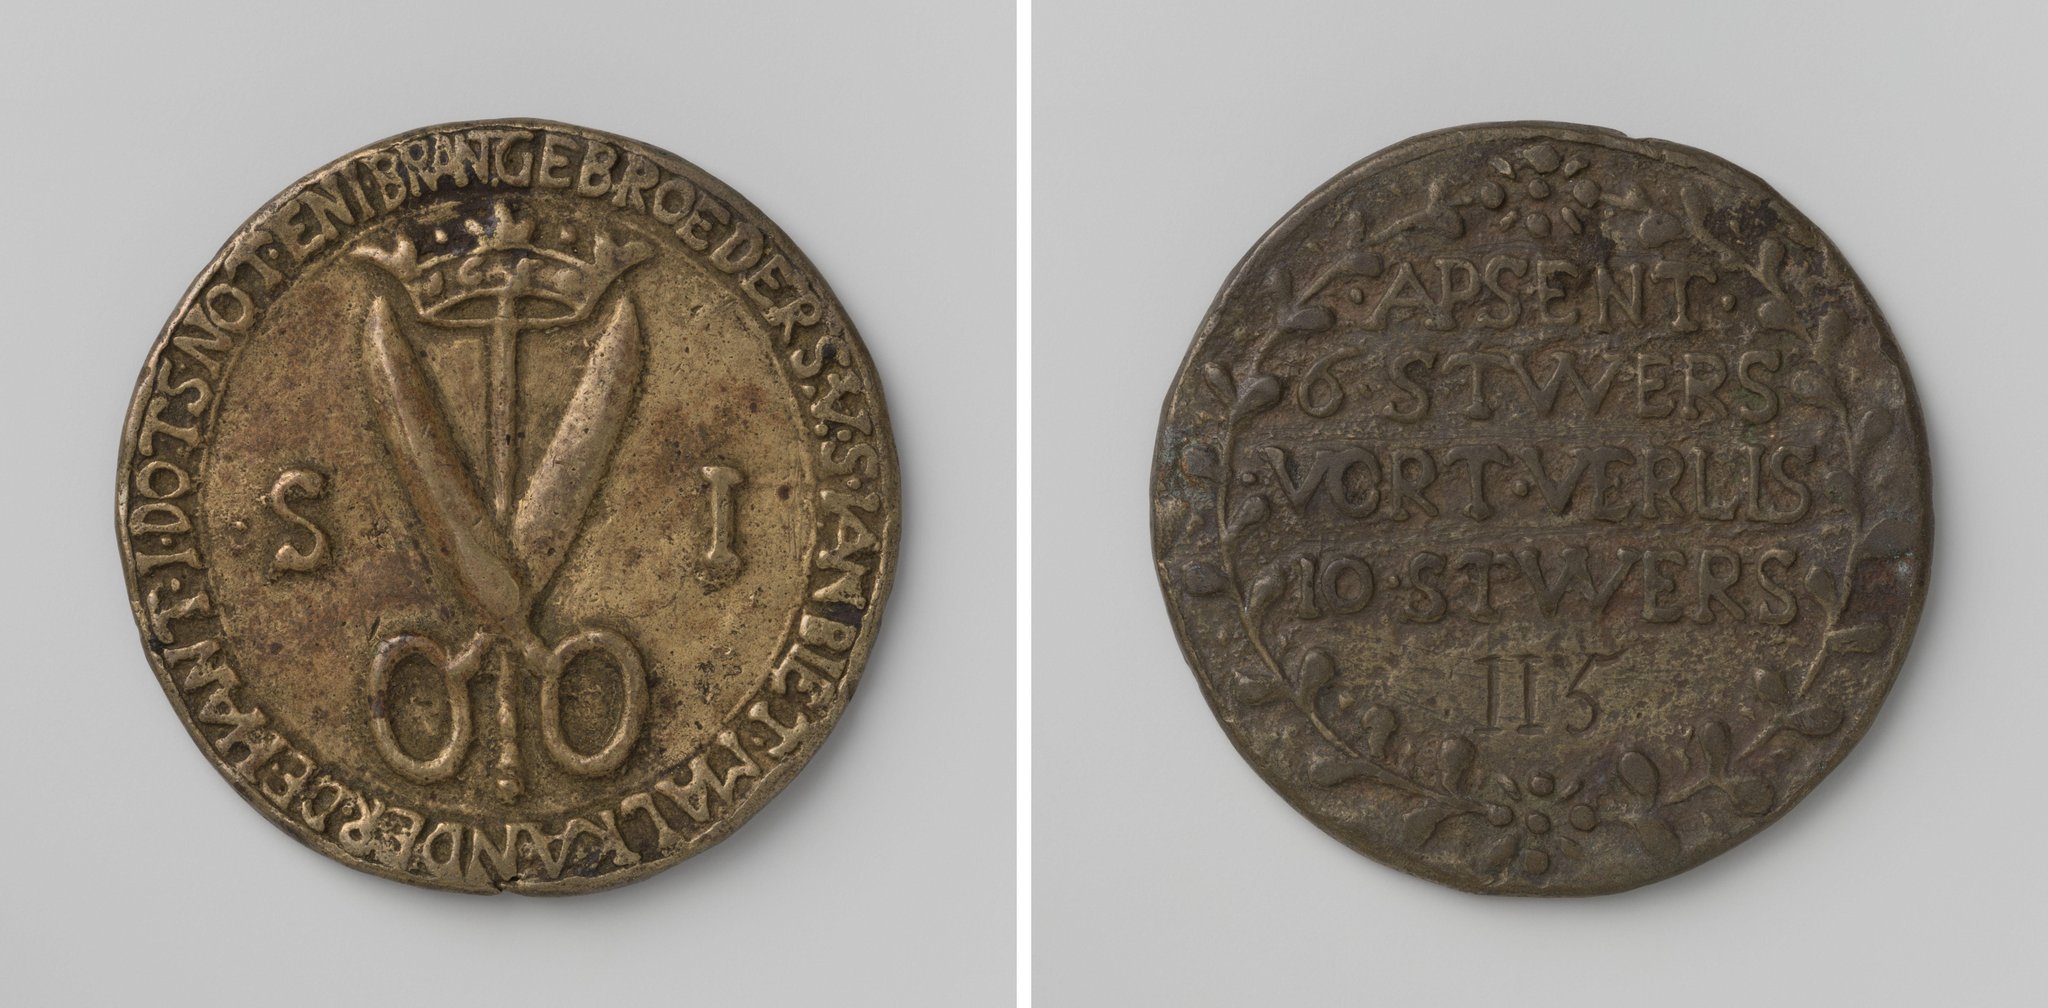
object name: medal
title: Kleermakersgilde van 's-Gravenhage, gildepenning met no. 115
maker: Anonymous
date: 1650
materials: brass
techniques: casting, engraving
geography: the hague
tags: the hague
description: Messing penning. Voorzijde: geopende schaar en kleermakersnaald onder kroon tussen letters S en I binnen omschrift; op kroon: jaartal. Keerzijde: opschrift boven cijfer 115 binnen krans van myrtetakken